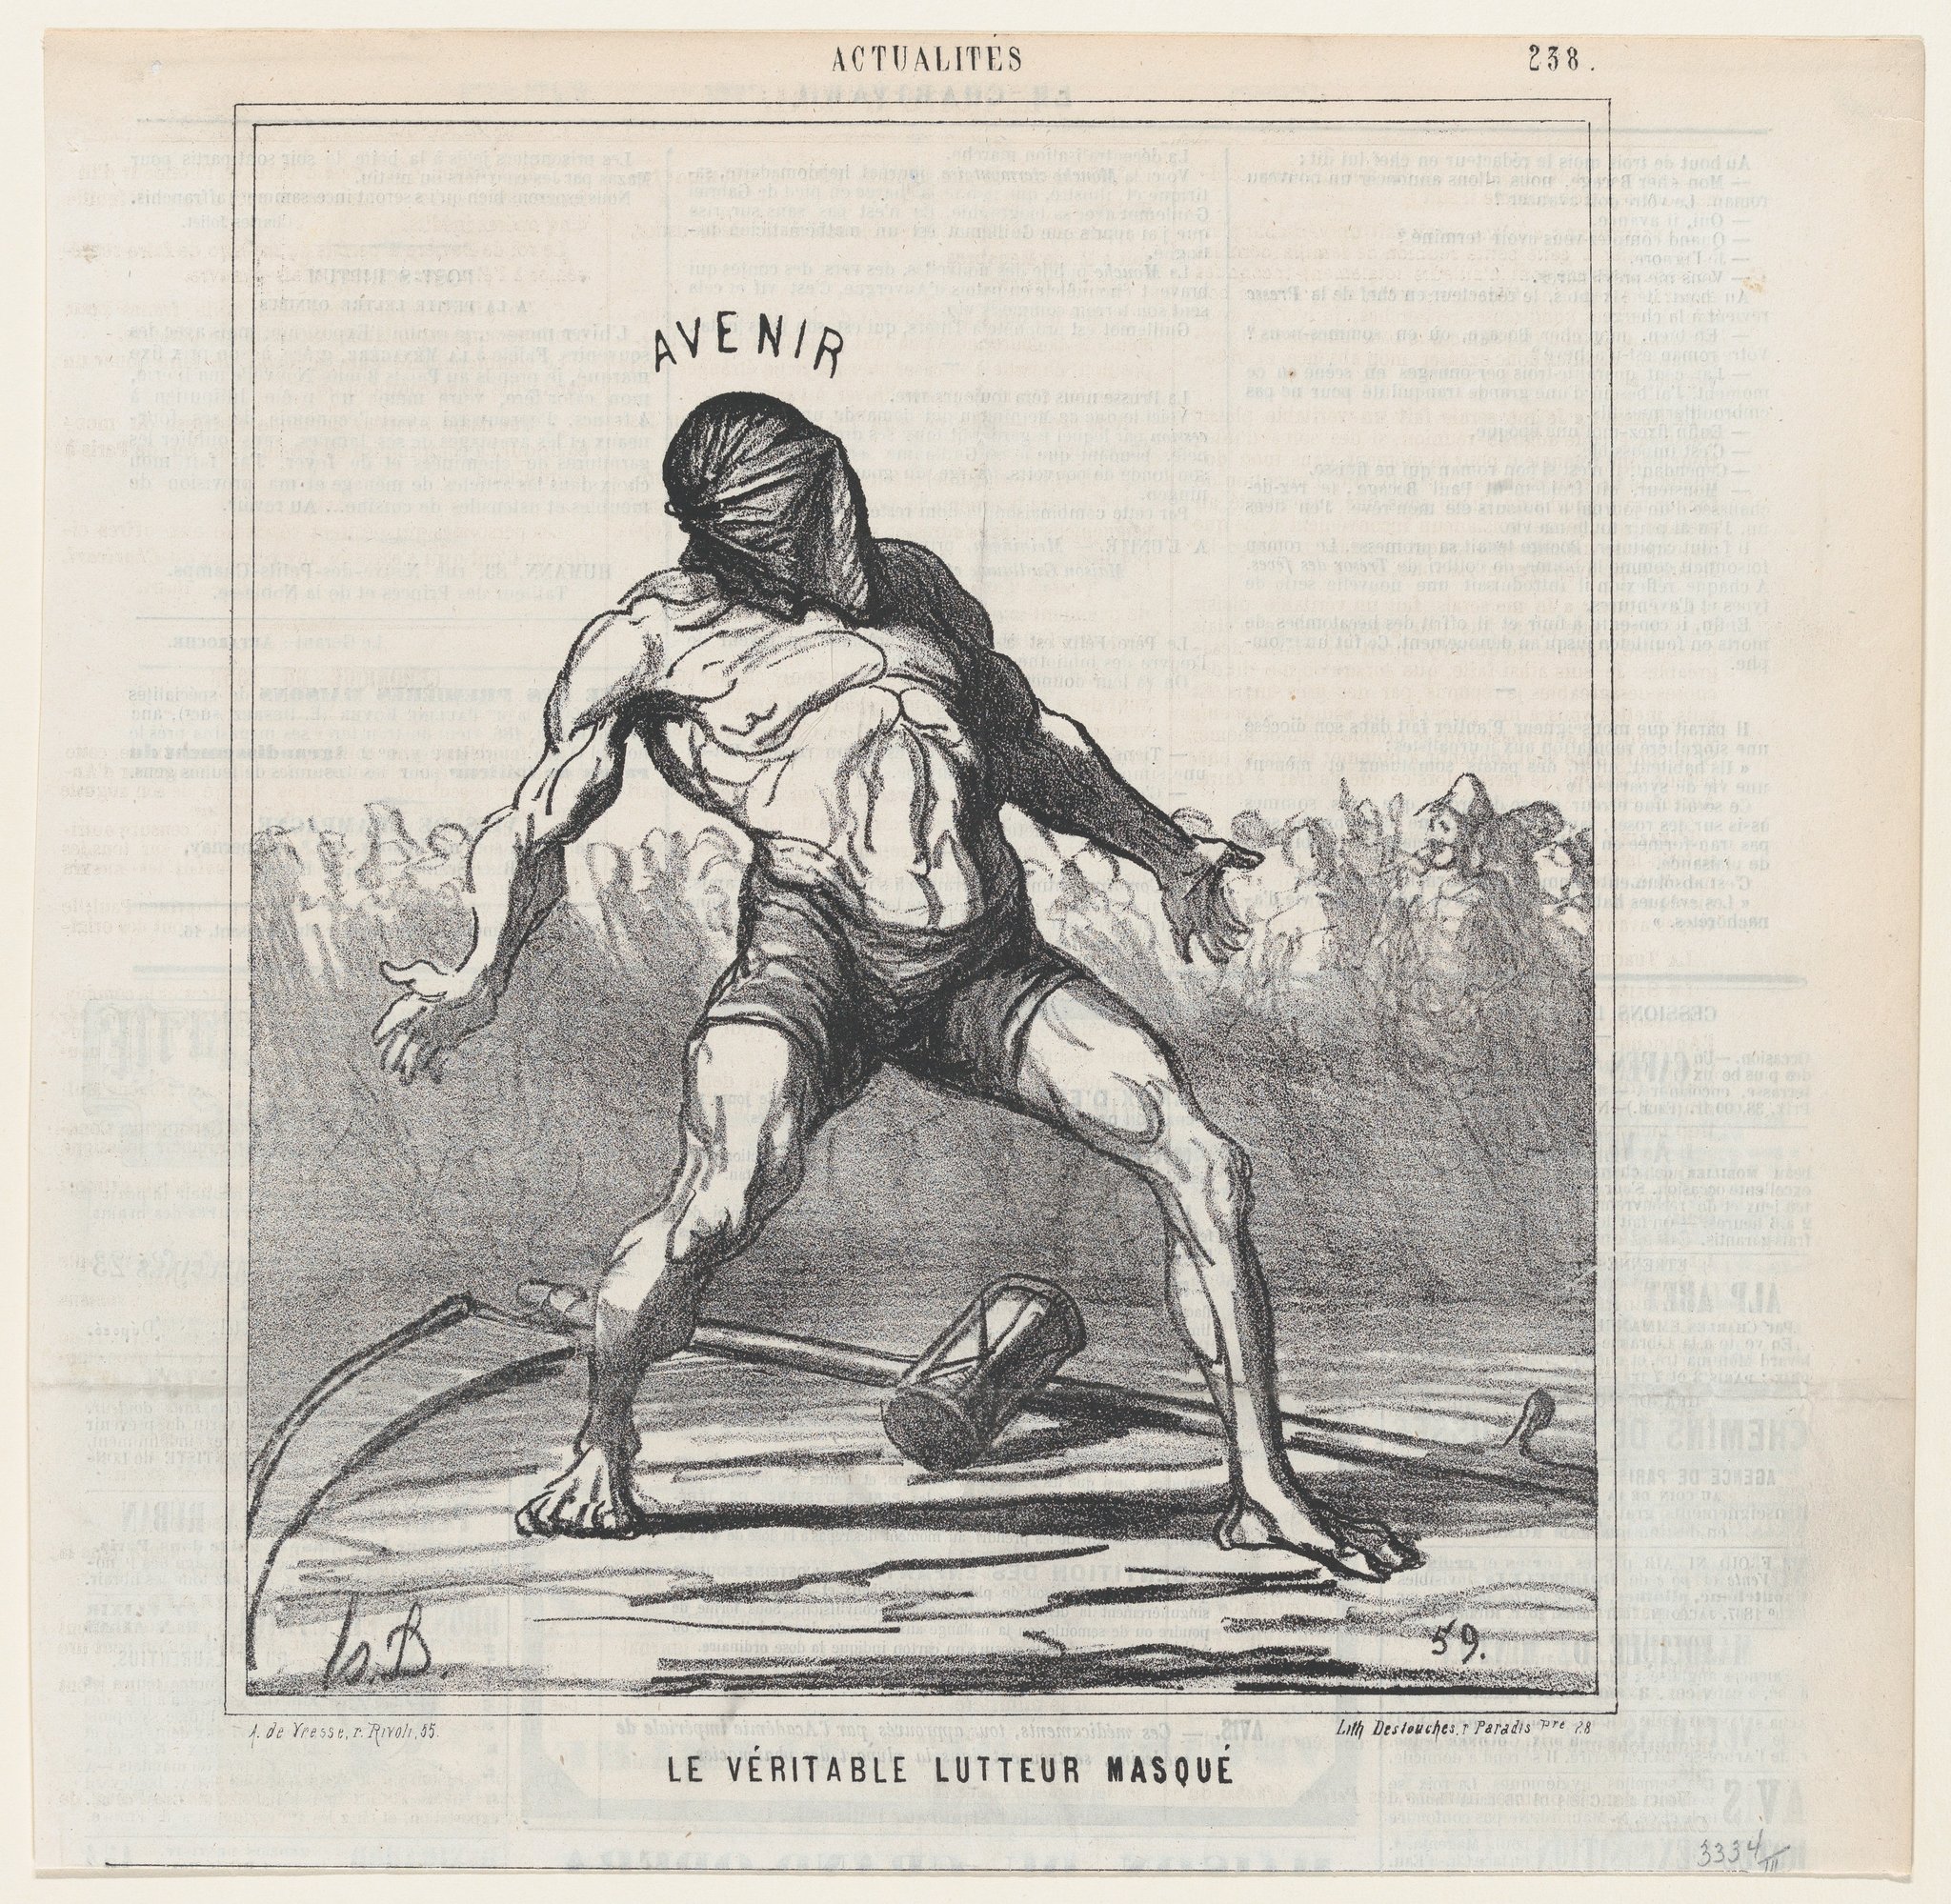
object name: print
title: The real masked fighter, from 'News of the day,' published in "Le Charivari"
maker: honoré daumier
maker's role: artist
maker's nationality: french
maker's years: 1808-1879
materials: paper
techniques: lithograph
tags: masks,weapons,men